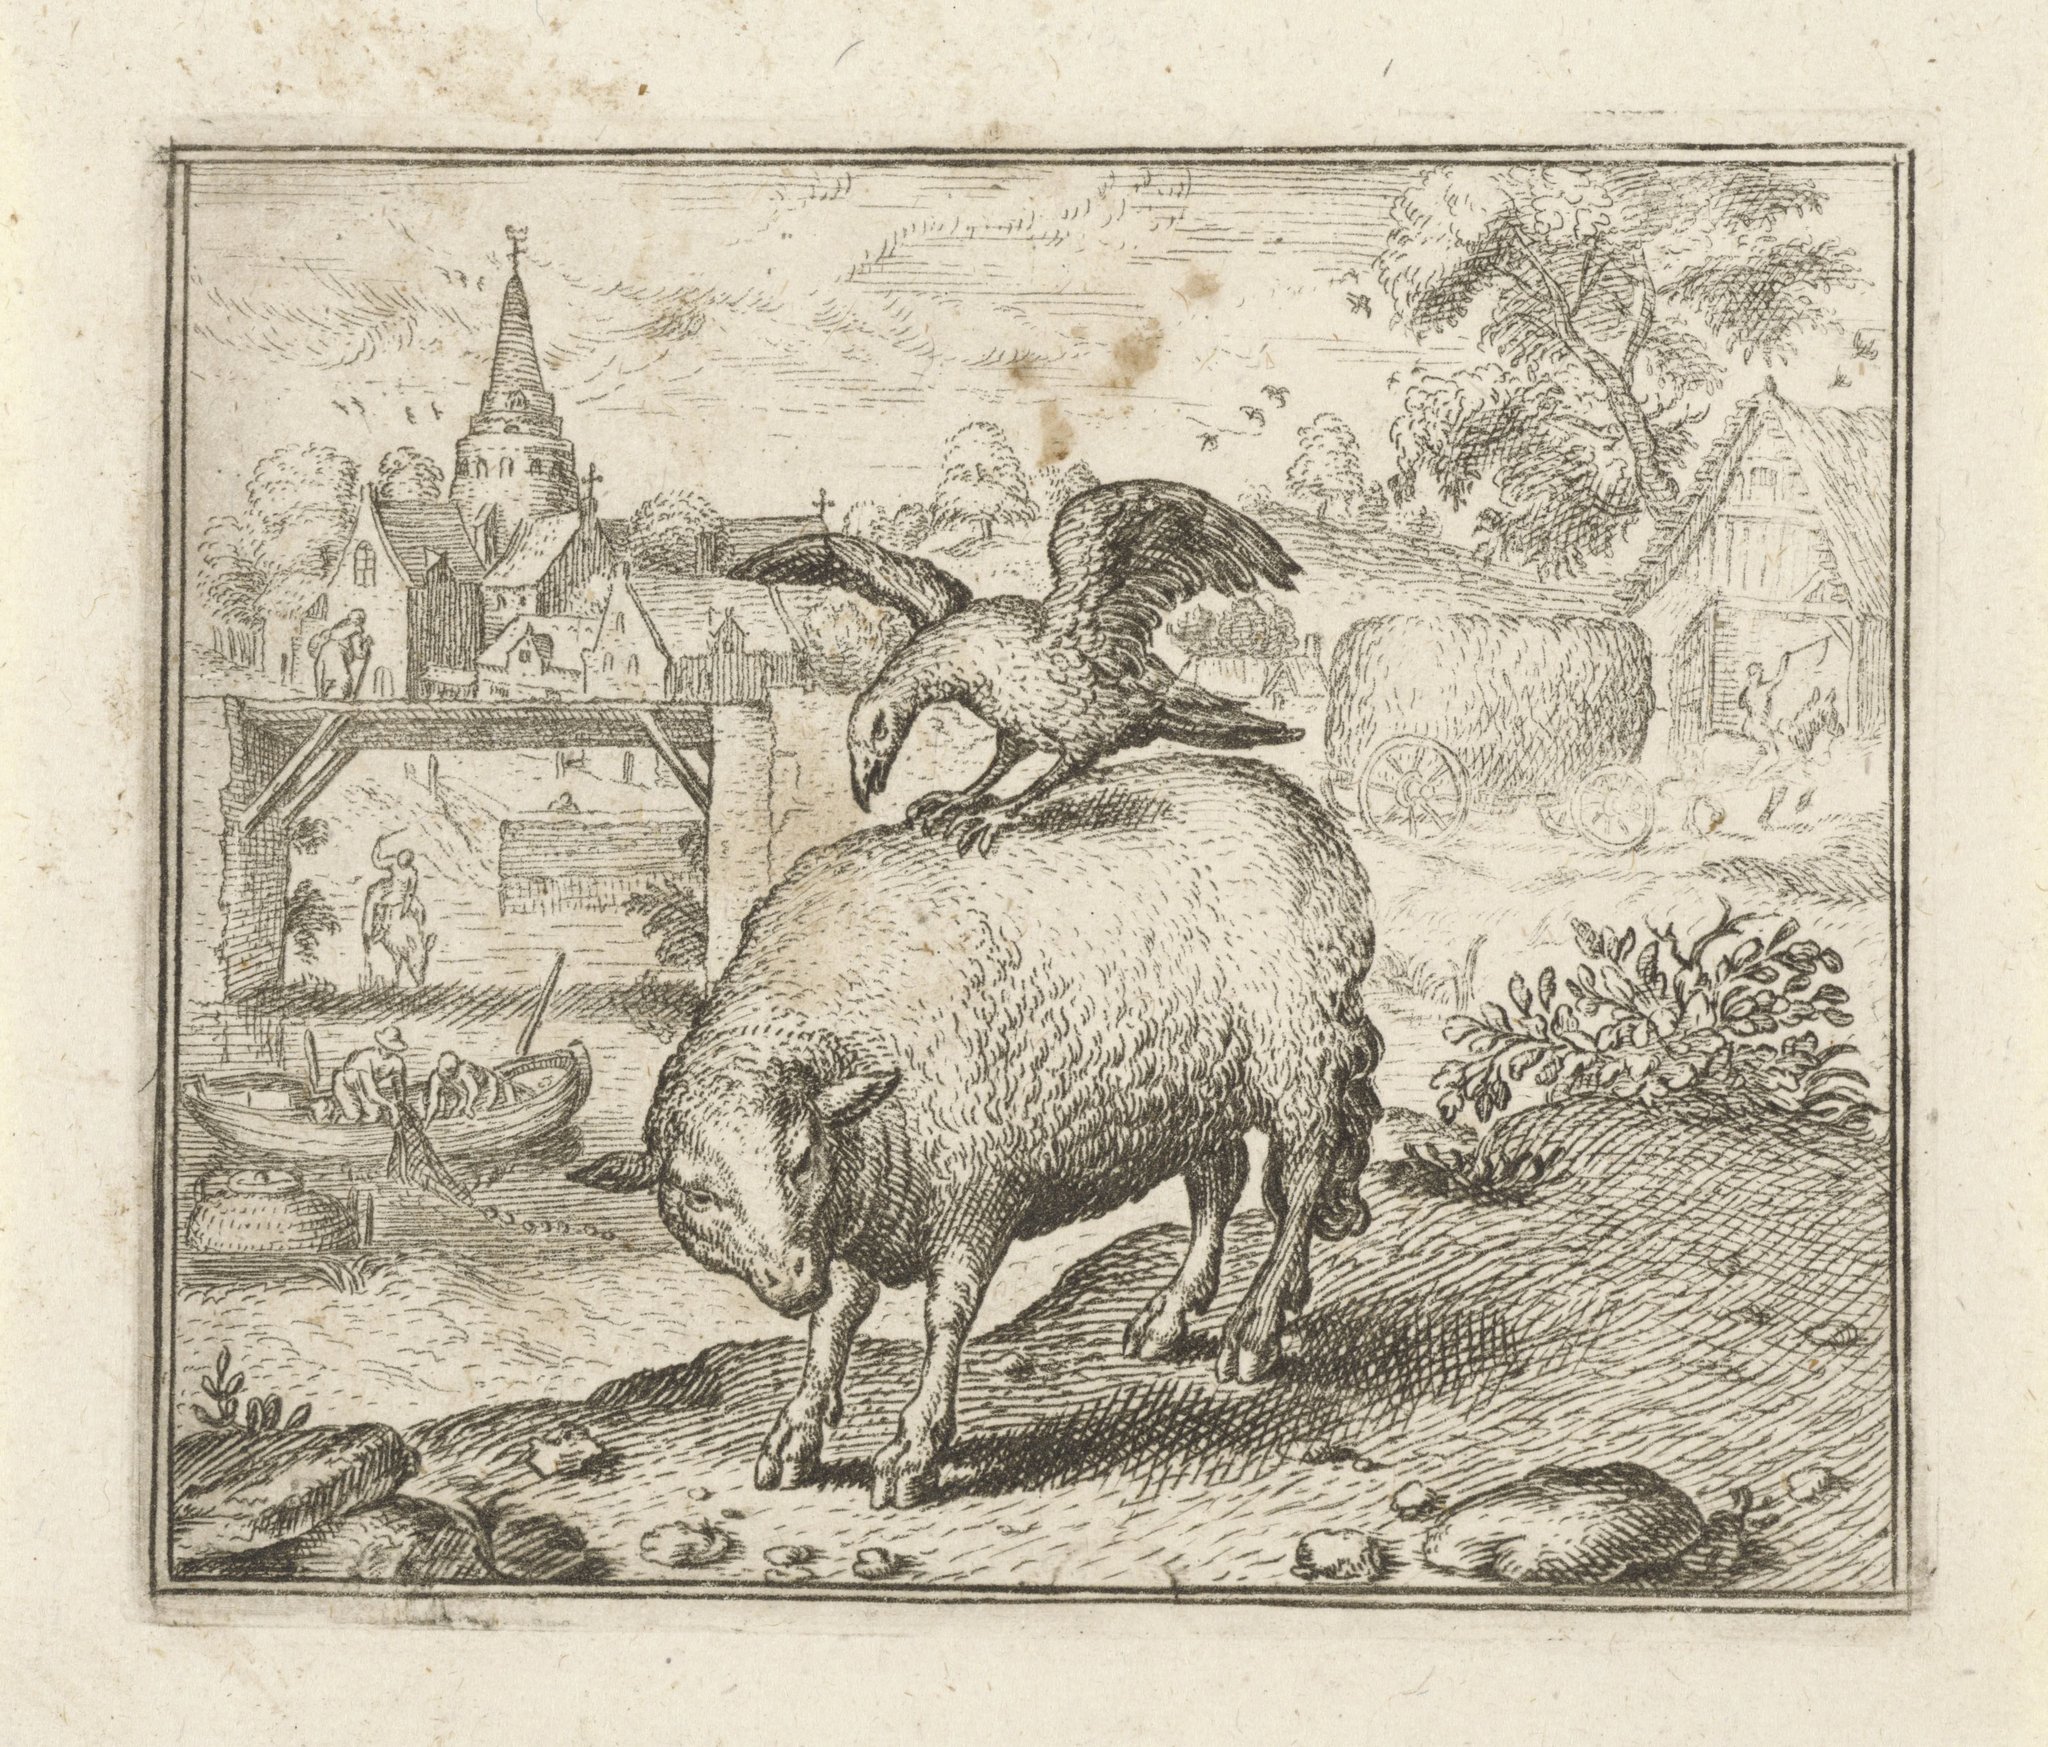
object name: print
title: Fabel van het schaap en de kraai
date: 1608-1679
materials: paper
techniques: etching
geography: prague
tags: song-birds: crow, sheep, fables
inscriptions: collector's mark: Lugt 2228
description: Een kraai zit op de rug van een schaap en pikt met zijn snavel in het schapenvel. De fabel beschrijft hoe de hongerige kraai zich tegoed doet aan het bloed van het schaap. De smeekbeden van het schaap helpen niet. De moraal van het verhaal leert dat men niet moet onderhandelen met tirannen.